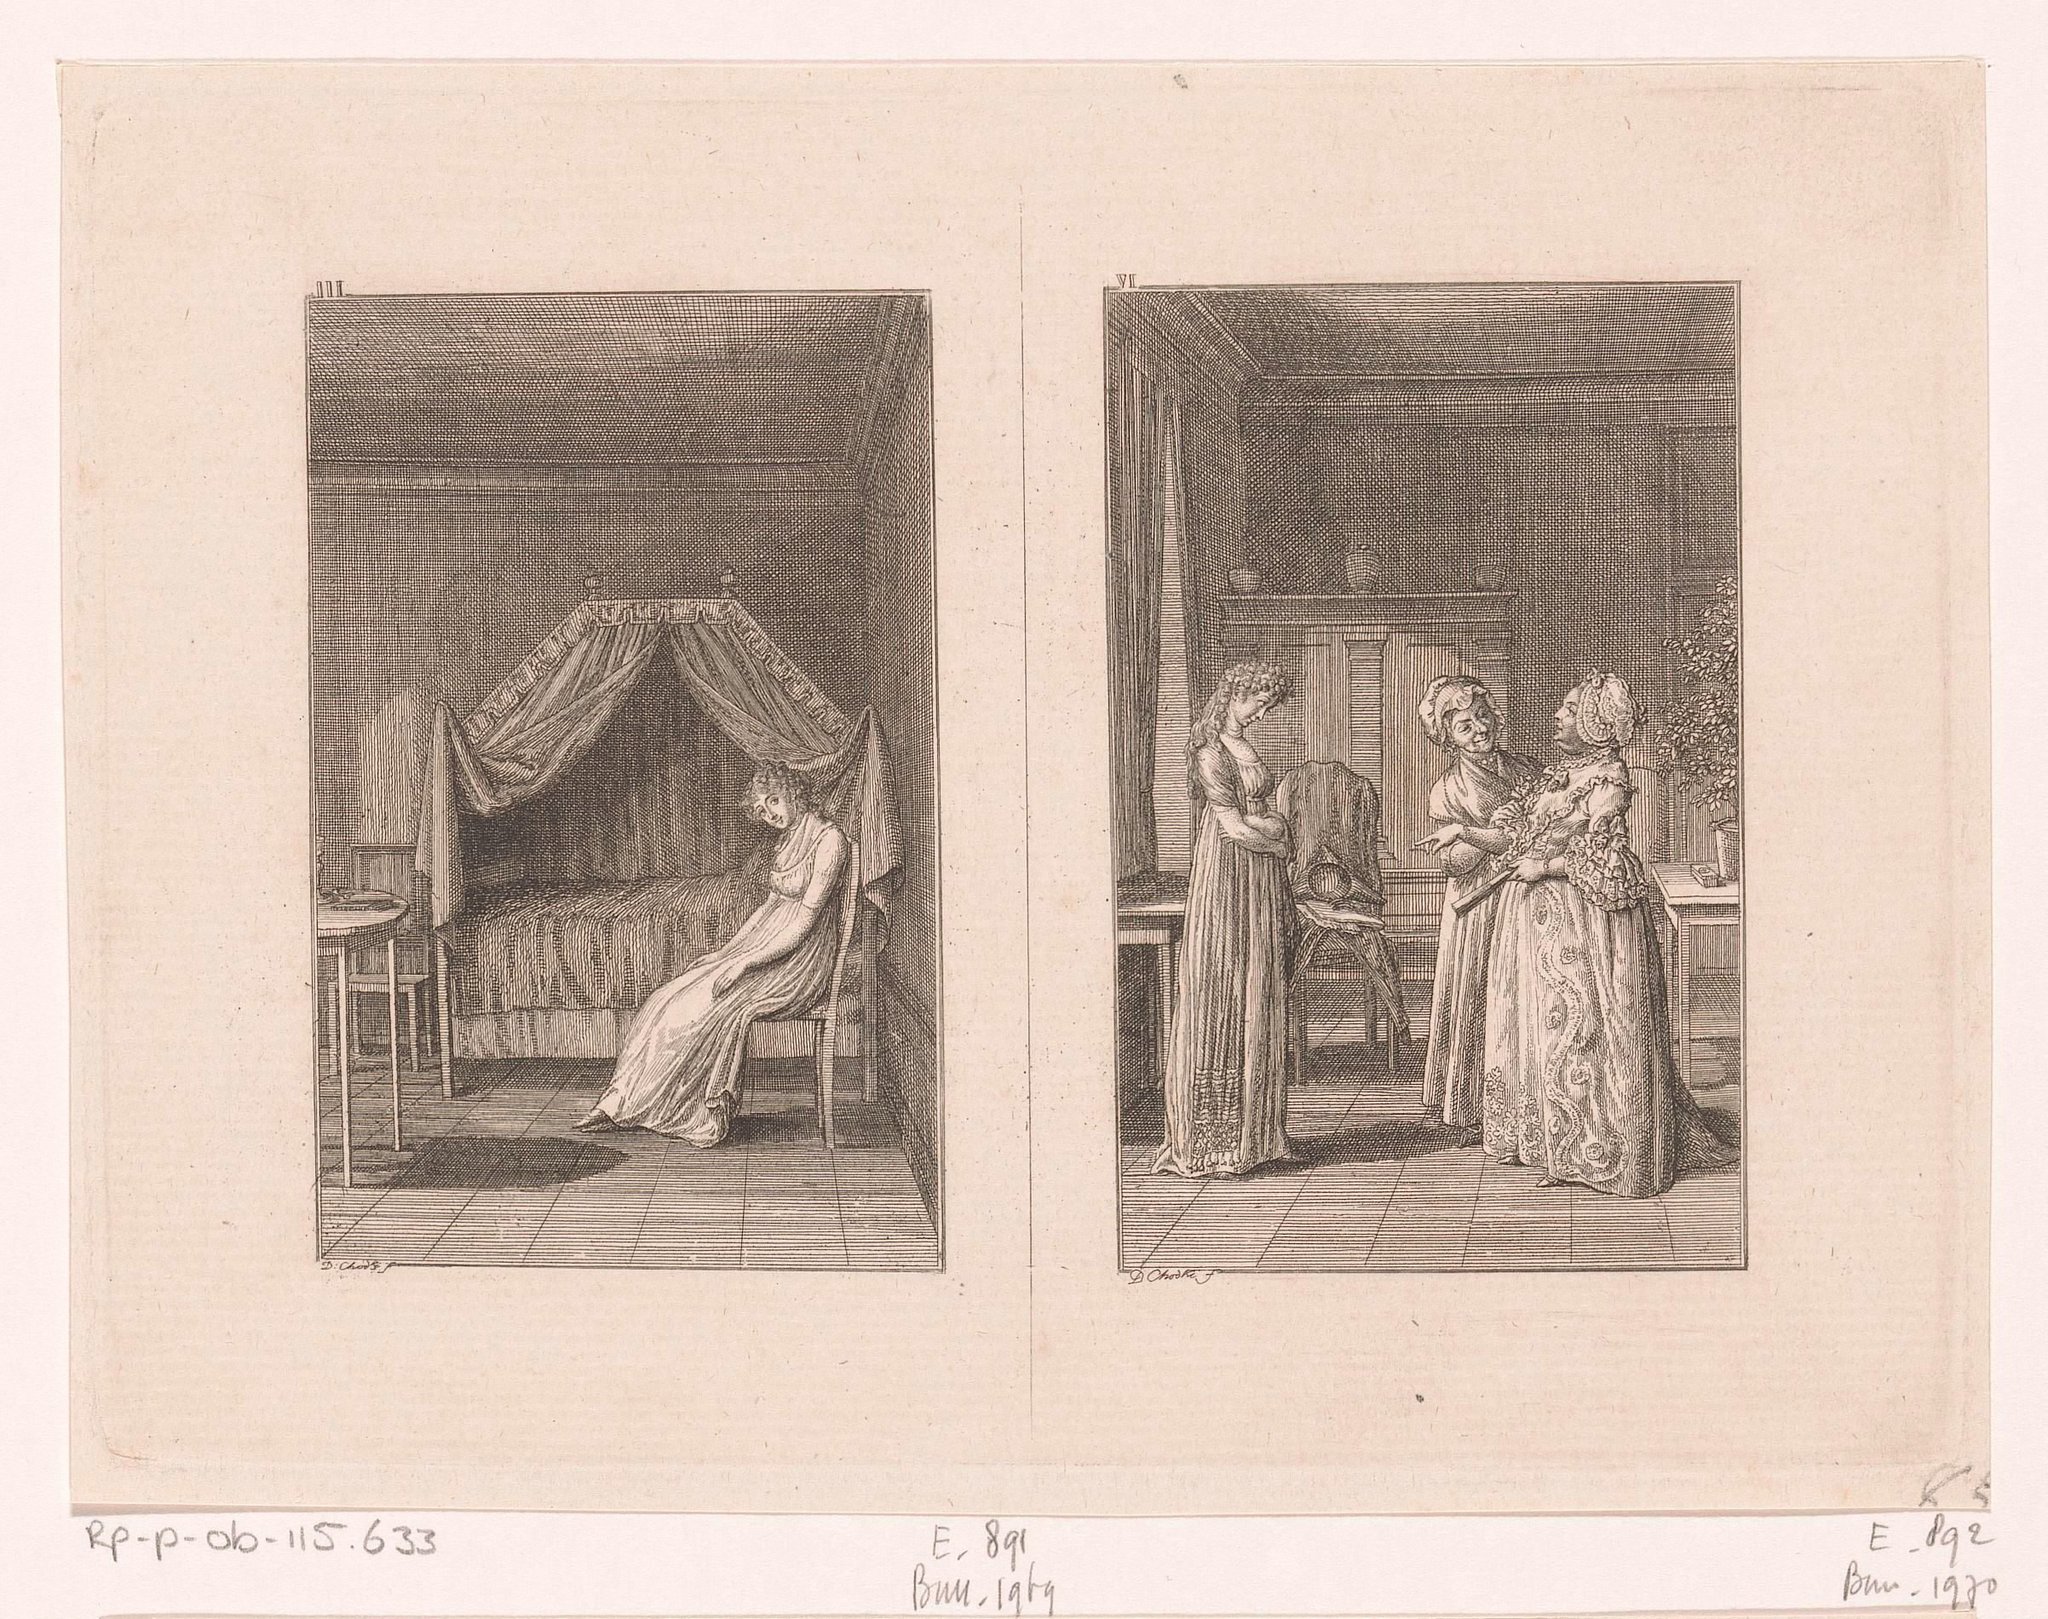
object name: print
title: Twee voorstellingen uit de verhalen van Wilhelm Gottlieb Becker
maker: daniel nikolaus chodowiecki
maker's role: draughtsman, print maker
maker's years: 1726-1801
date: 1799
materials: paper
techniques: etching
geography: berlin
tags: adolescent, young woman, maiden, conversation, dialogue; conversation piece, bedroom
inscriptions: collector's mark: Lugt 2228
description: Prent gebruikt voor: Becker, Wilhelm Gottlieb. Almanach und Taschenbuch zum geselligen Vergnügen (...). Leipzig: Johann Christian Friedrich Roch, [1800].